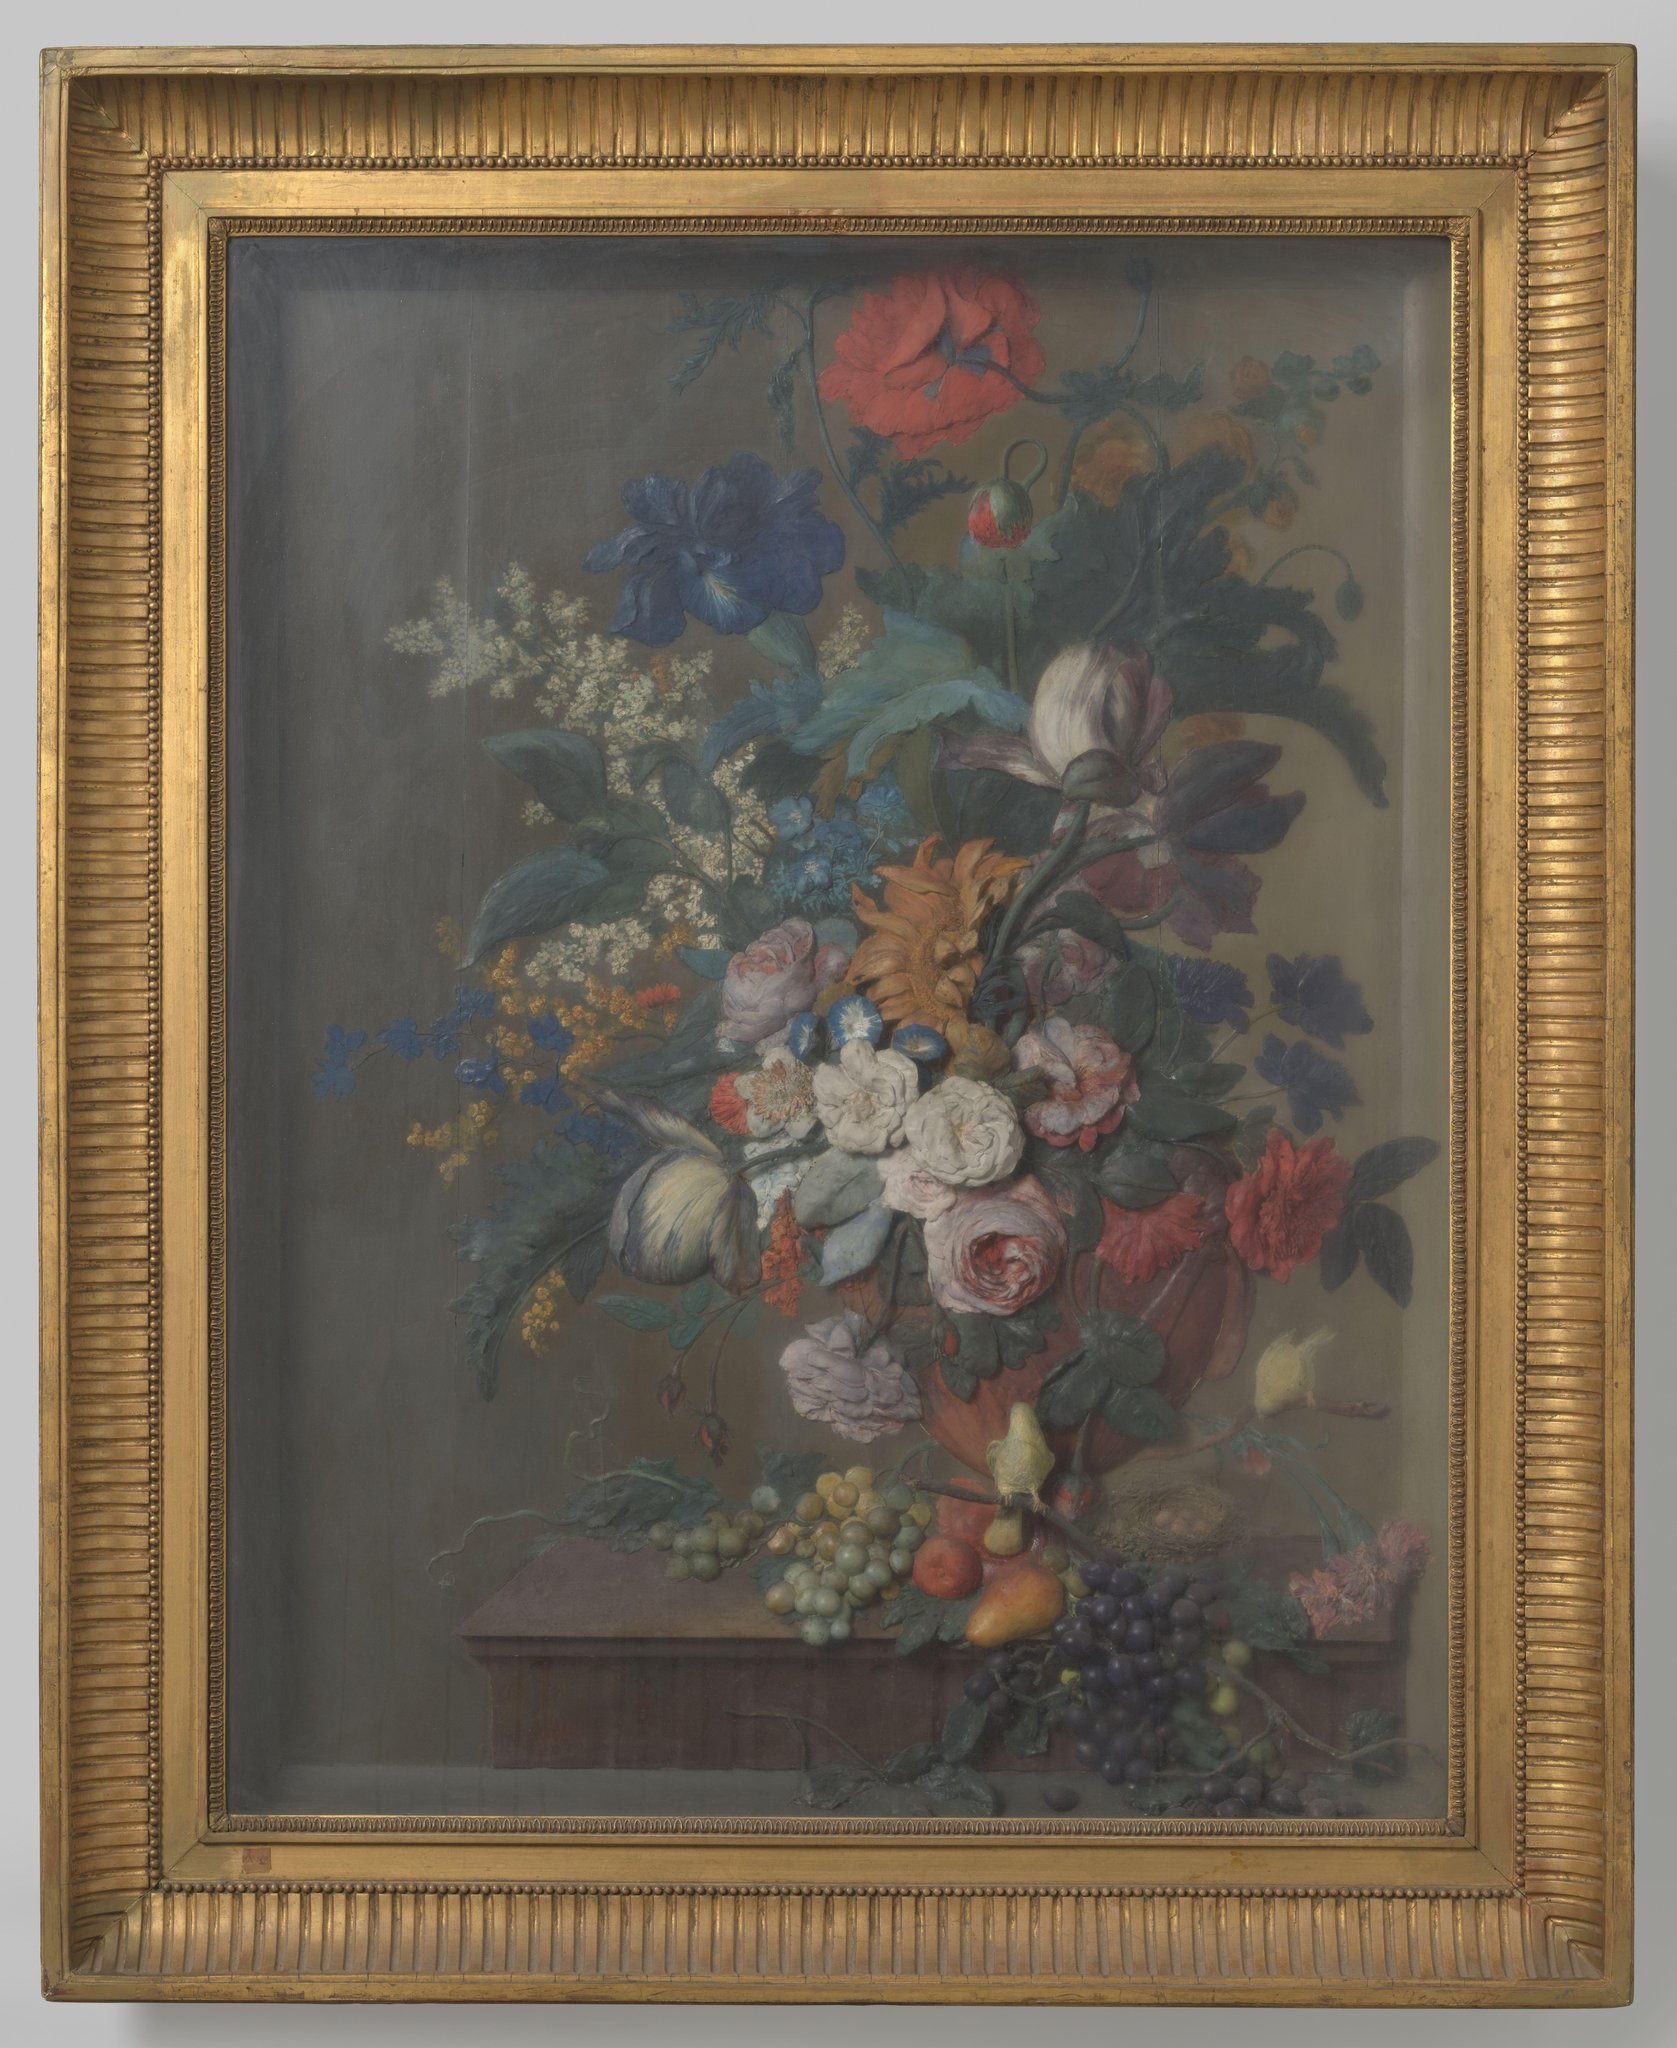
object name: relief sculpture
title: Vaas met bloemen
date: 1400-1950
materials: wood